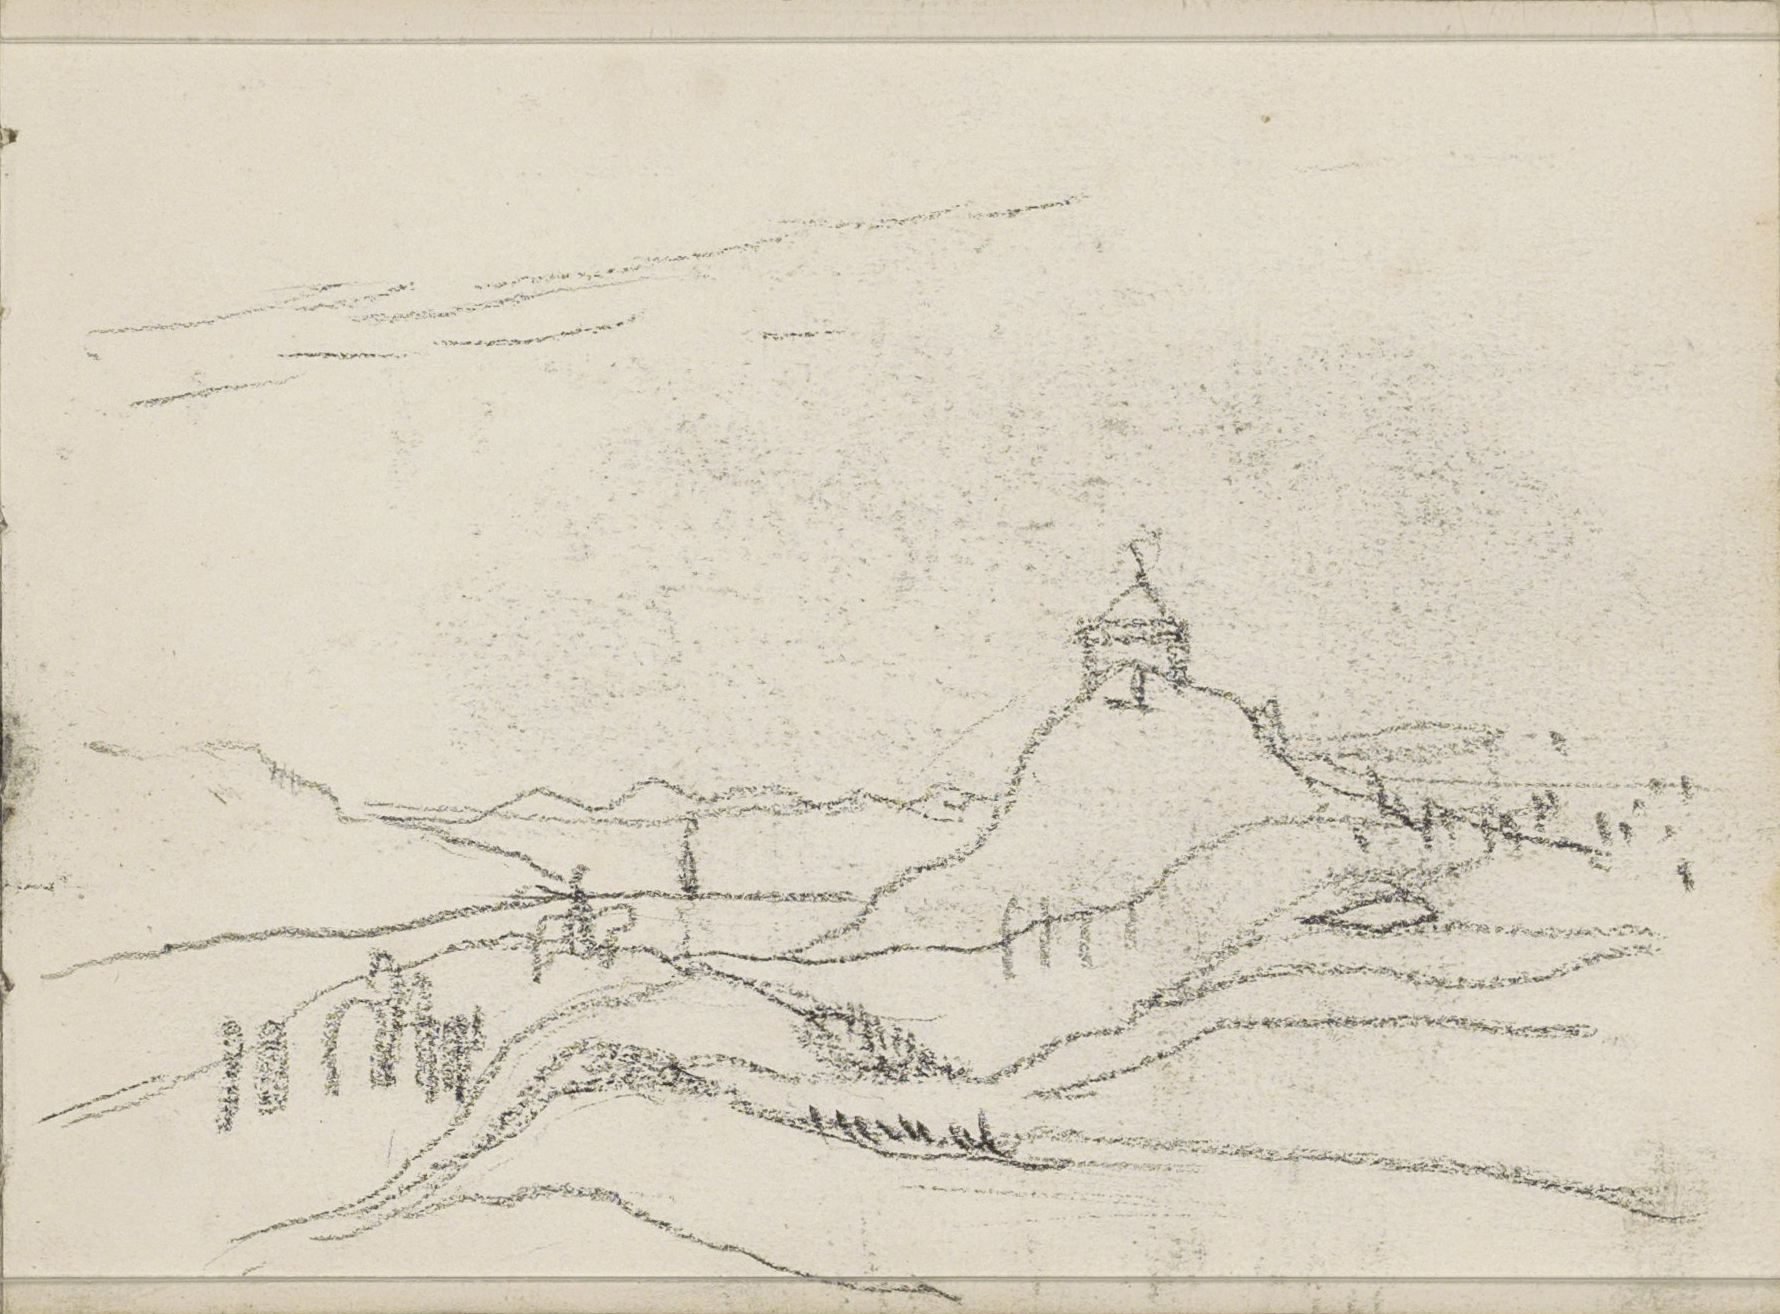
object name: sketchbook leaf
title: Landschap met figuren en een toren op een heuvel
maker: anton mauve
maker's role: draughtsman, painter, print maker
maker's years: 1838-1888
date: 1848-1888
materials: chalk, paper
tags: city-view, and landscape with man-made constructions, low hill country (+ landscape with figures, staffage)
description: Blad 2 recto uit een schetsboek met 33 bladen.